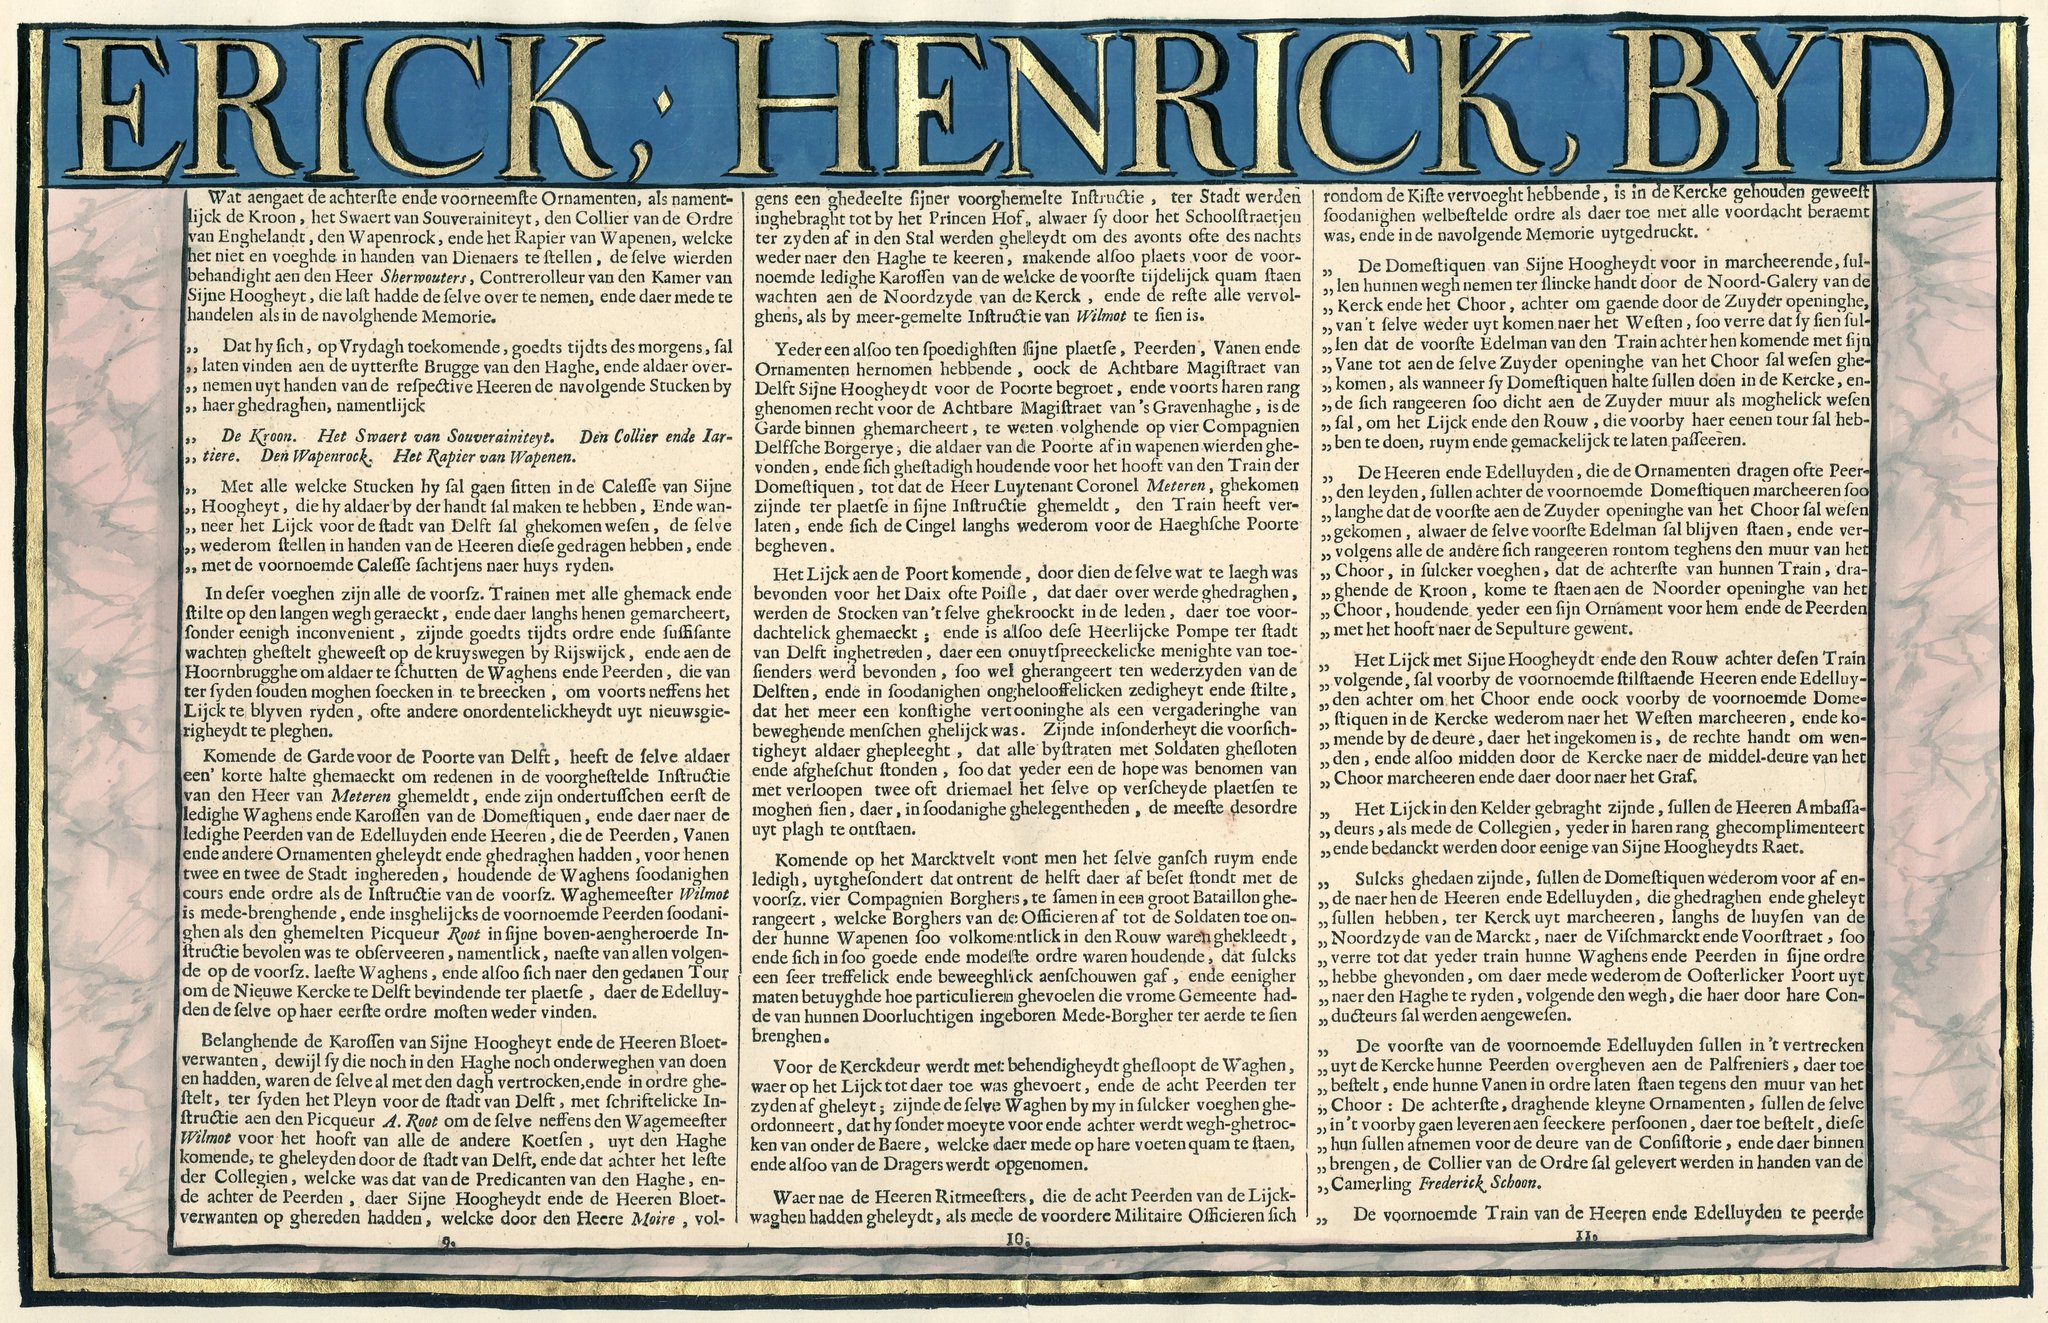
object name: text sheet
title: Programma van de begrafenis van Frederik Hendrik, p. 09-11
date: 1651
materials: paint, paper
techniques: colour, letterpress printing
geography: the hague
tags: delft, frederick henry (prince of orange)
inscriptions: date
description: Pagina's 9-11 van het programma van de begrafenis van Frederik Hendrik. Blad in een gekleurde omlijsting versierd met goud en ingeplakt in de luxe editie uit ca. 1755 van het boek 'Begraeffenisse van syne hoogheyt Frederick Henrick' van Pieter Post, uitgegeven te Amsterdam in 1651.